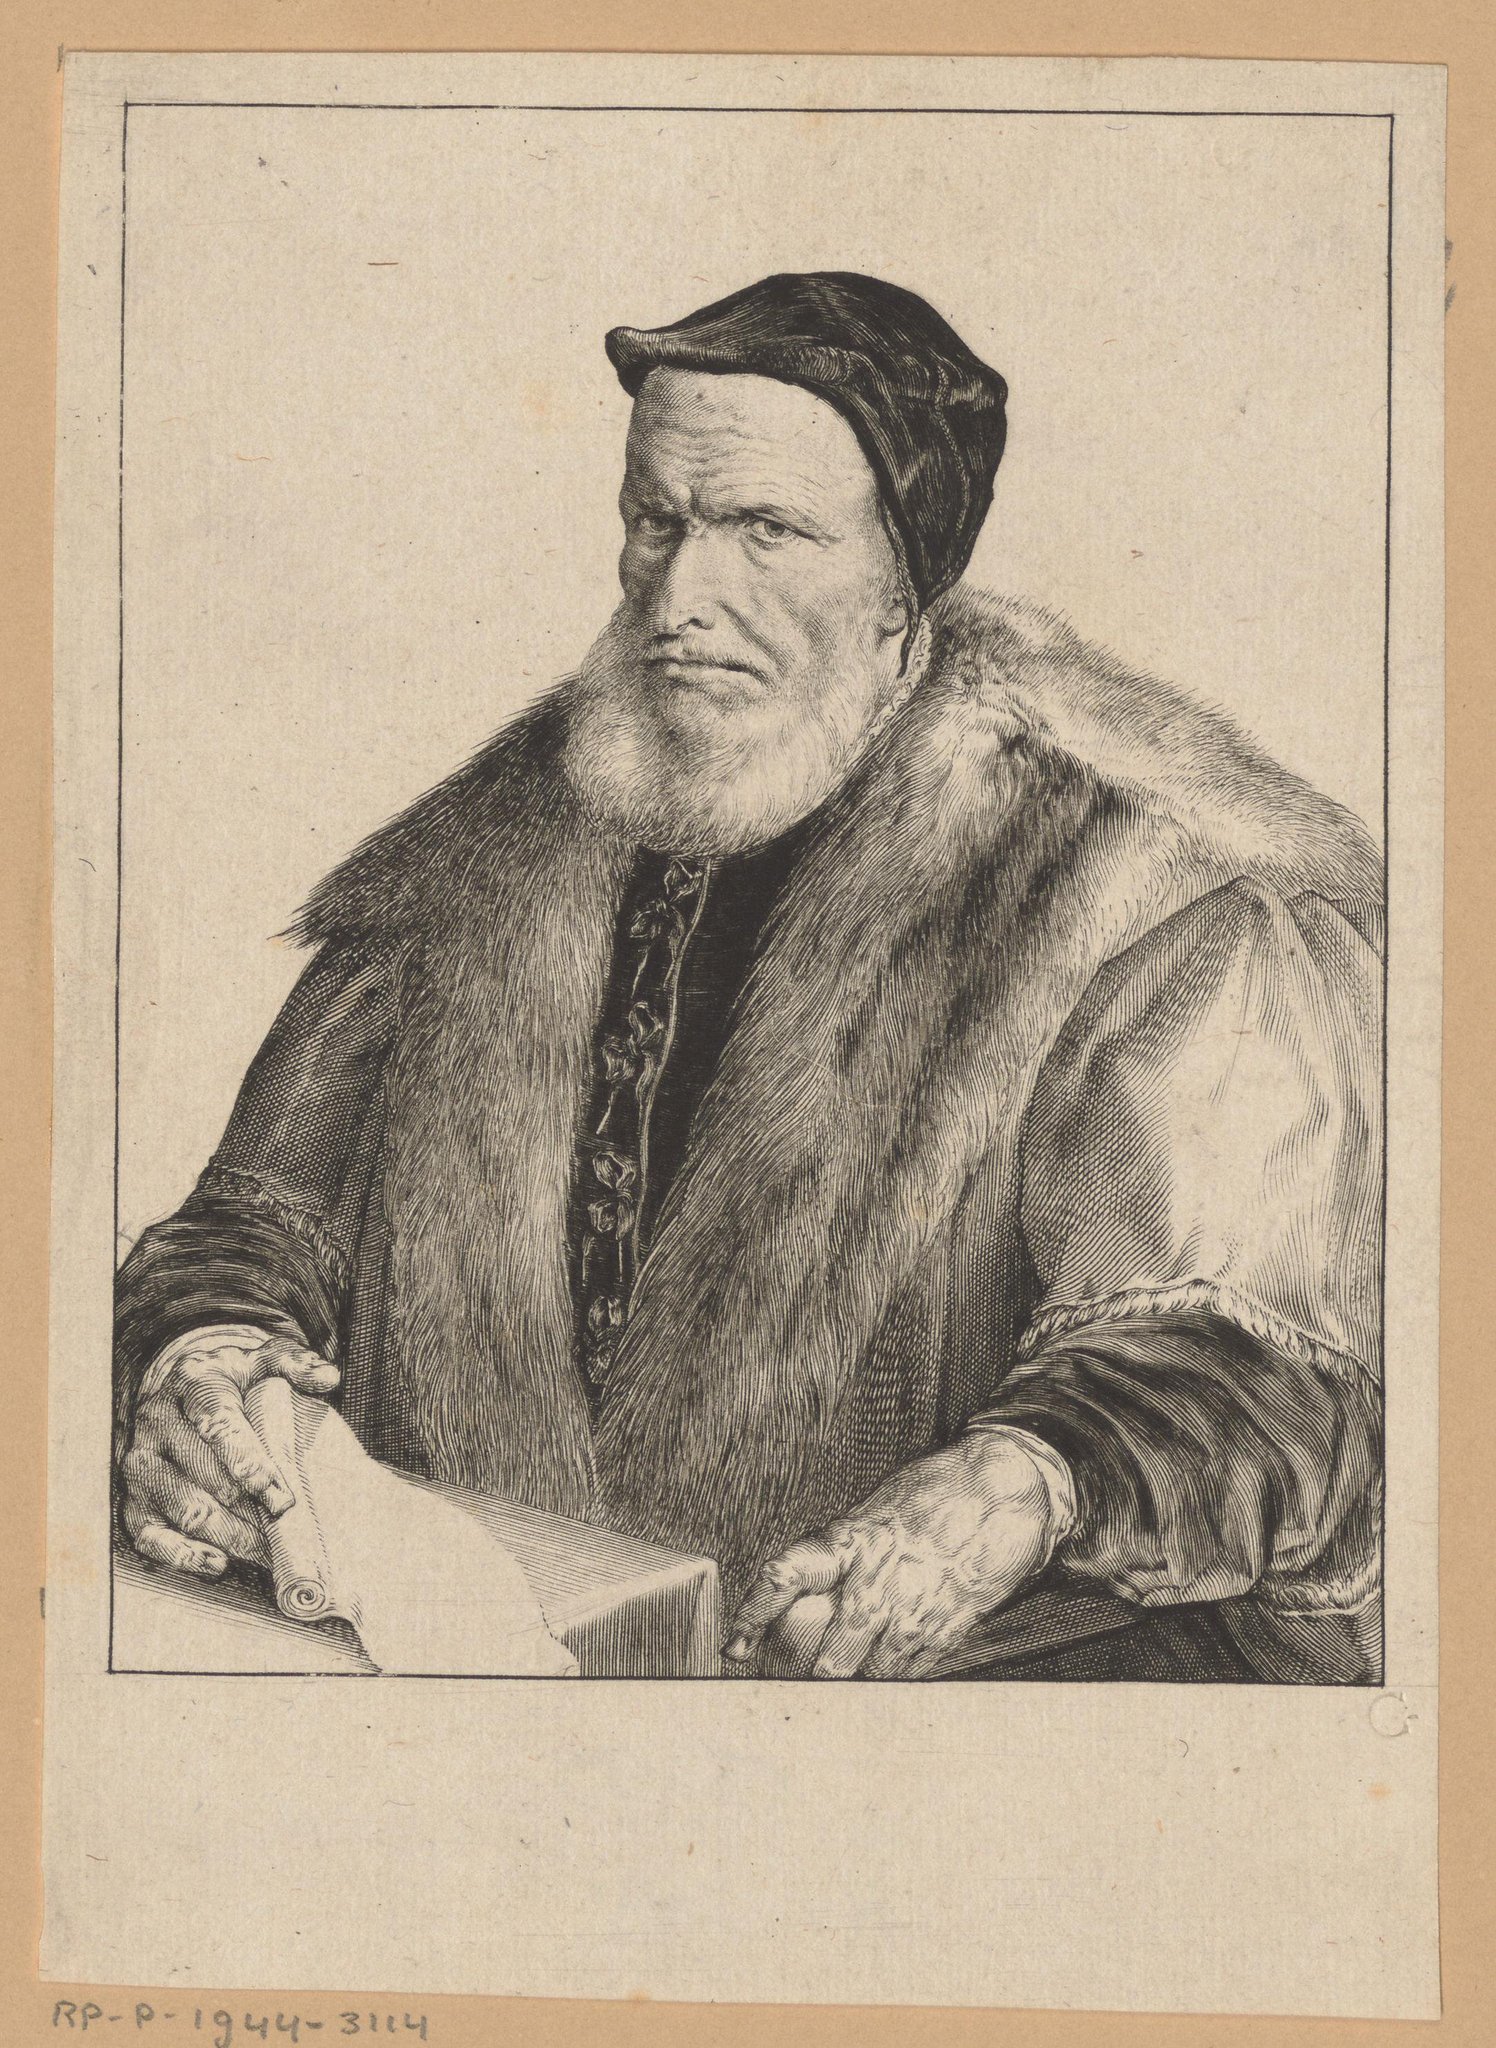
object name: print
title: Portret van Joost Sijbrandtsz. Buyck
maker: jan harmensz. muller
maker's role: draughtsman, print maker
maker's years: 1571-1628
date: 1588-1628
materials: paper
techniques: engraving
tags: mayor, mayor, burgomaster, historical persons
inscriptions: collector's mark: Lugt 2228